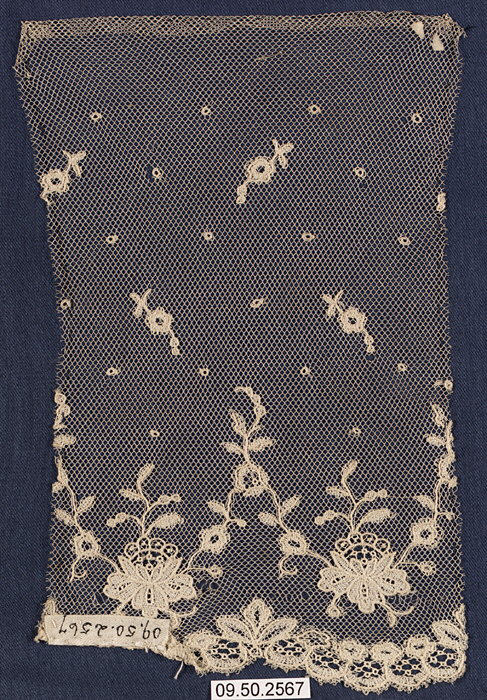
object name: fragment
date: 1801-1900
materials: lace